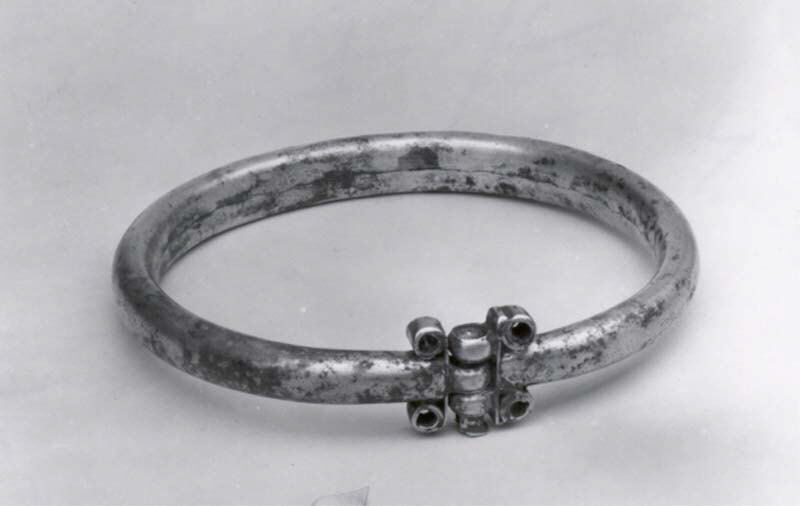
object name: bracelet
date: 401-600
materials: silver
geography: iran